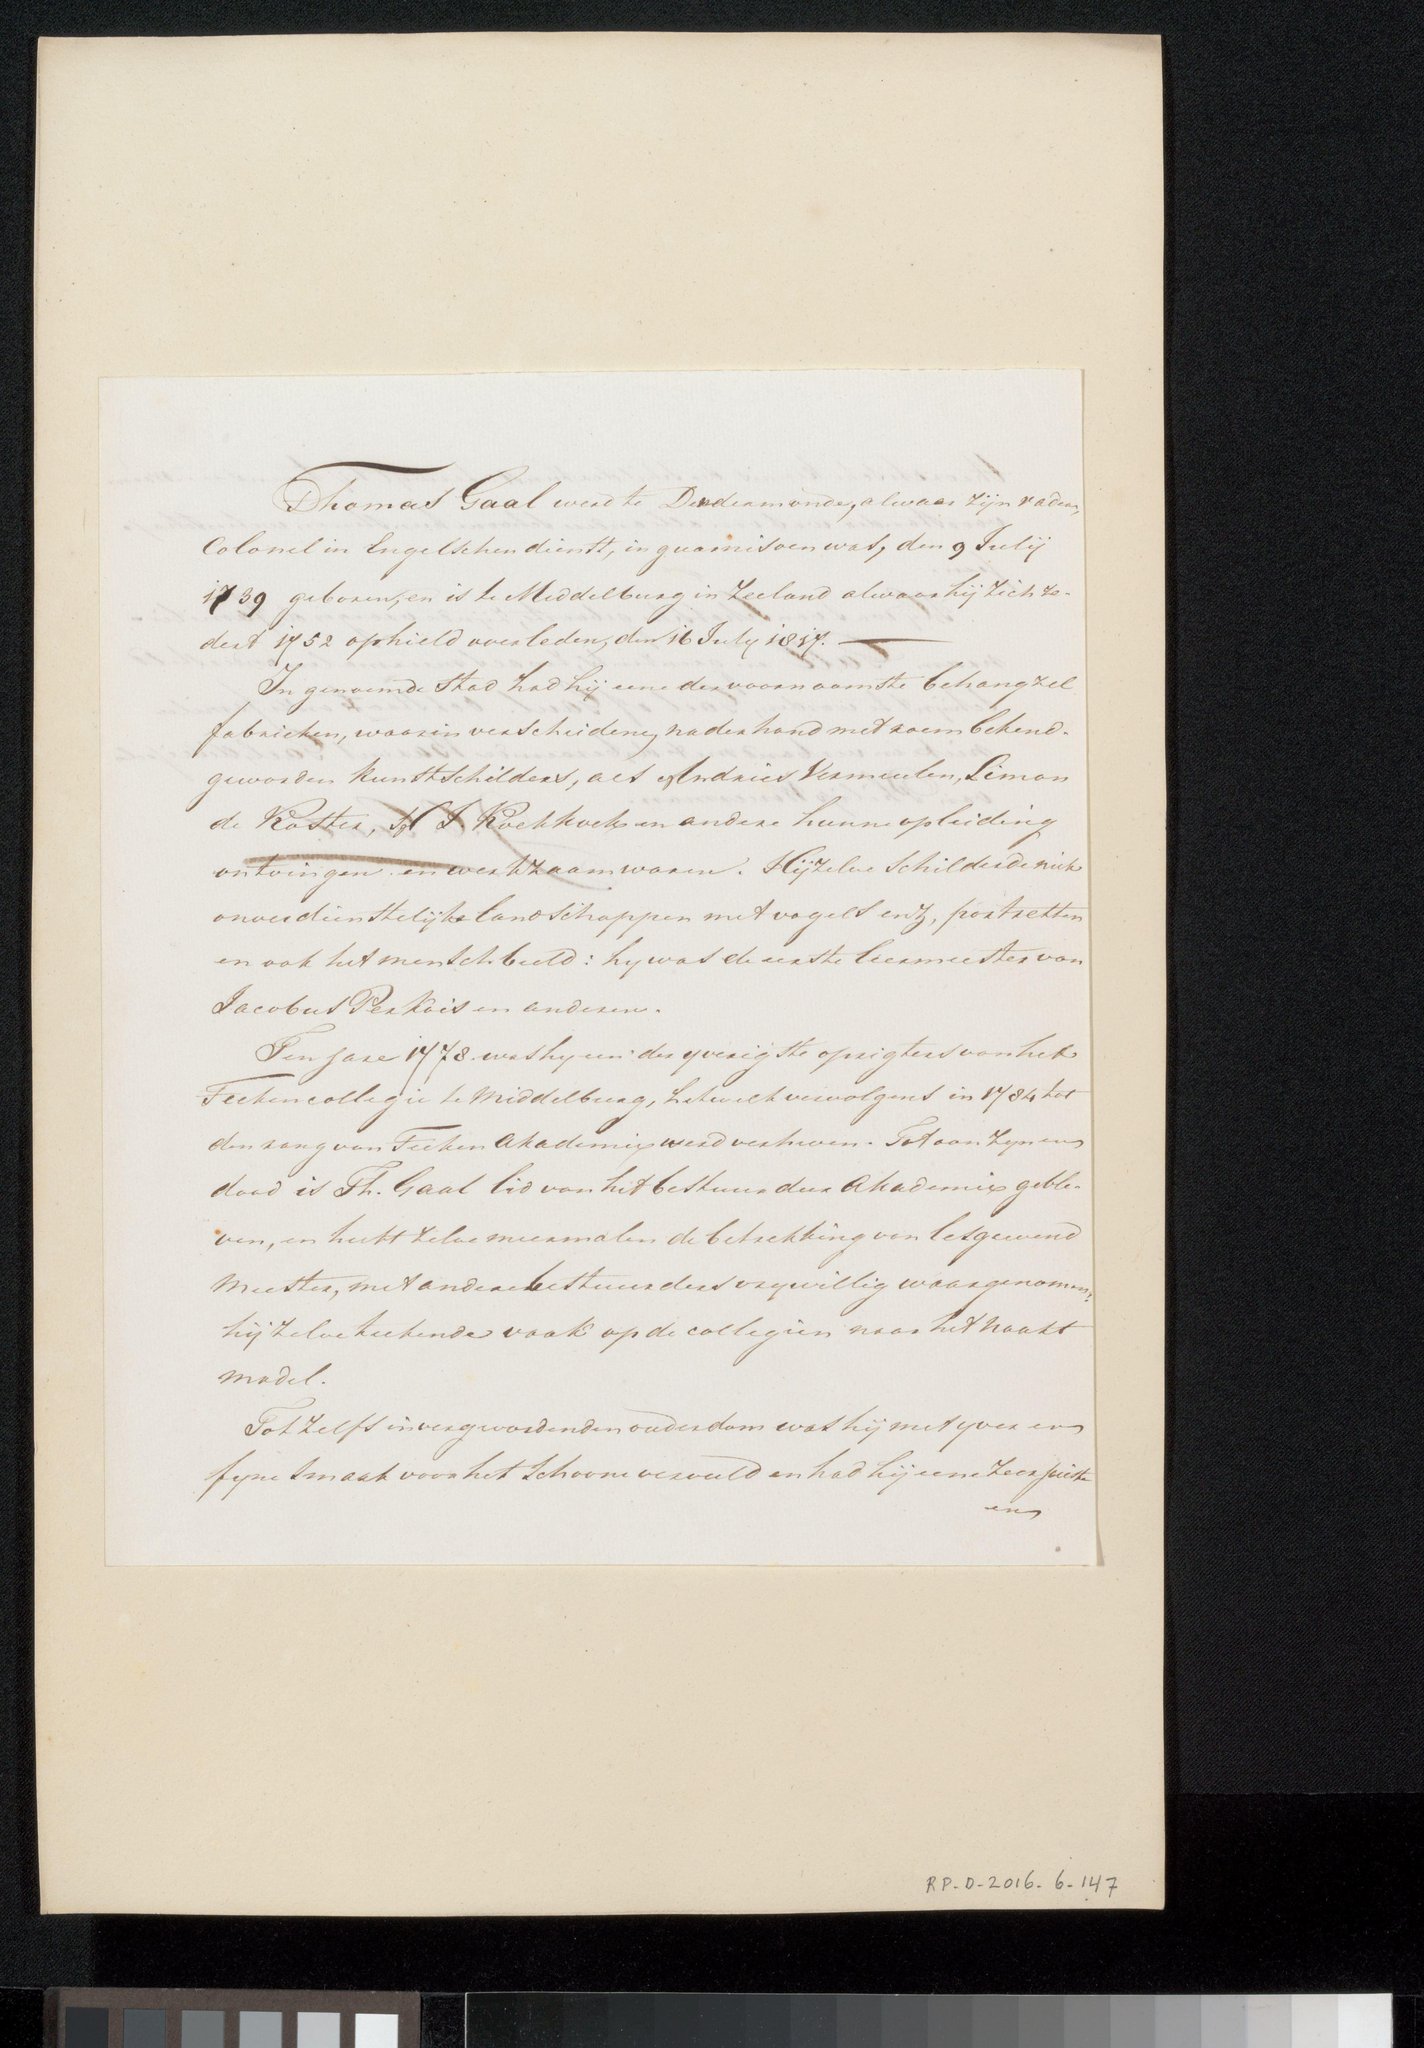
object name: manuscript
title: Handschrift betreffende Thomas Gaal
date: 1840-1841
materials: ink, paper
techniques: pen, writing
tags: painter, thomas gaal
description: Opgenomen in: Immerzeel, J. Jr., De levens en werken der Hollandsche en Vlaamsche kunstschilders, beeldhouwers, graveurs en bouwmeesters, van het begin der vijftiende eeuw tot heden, Amsterdam: J.C. van Kesteren, 1842-1843.